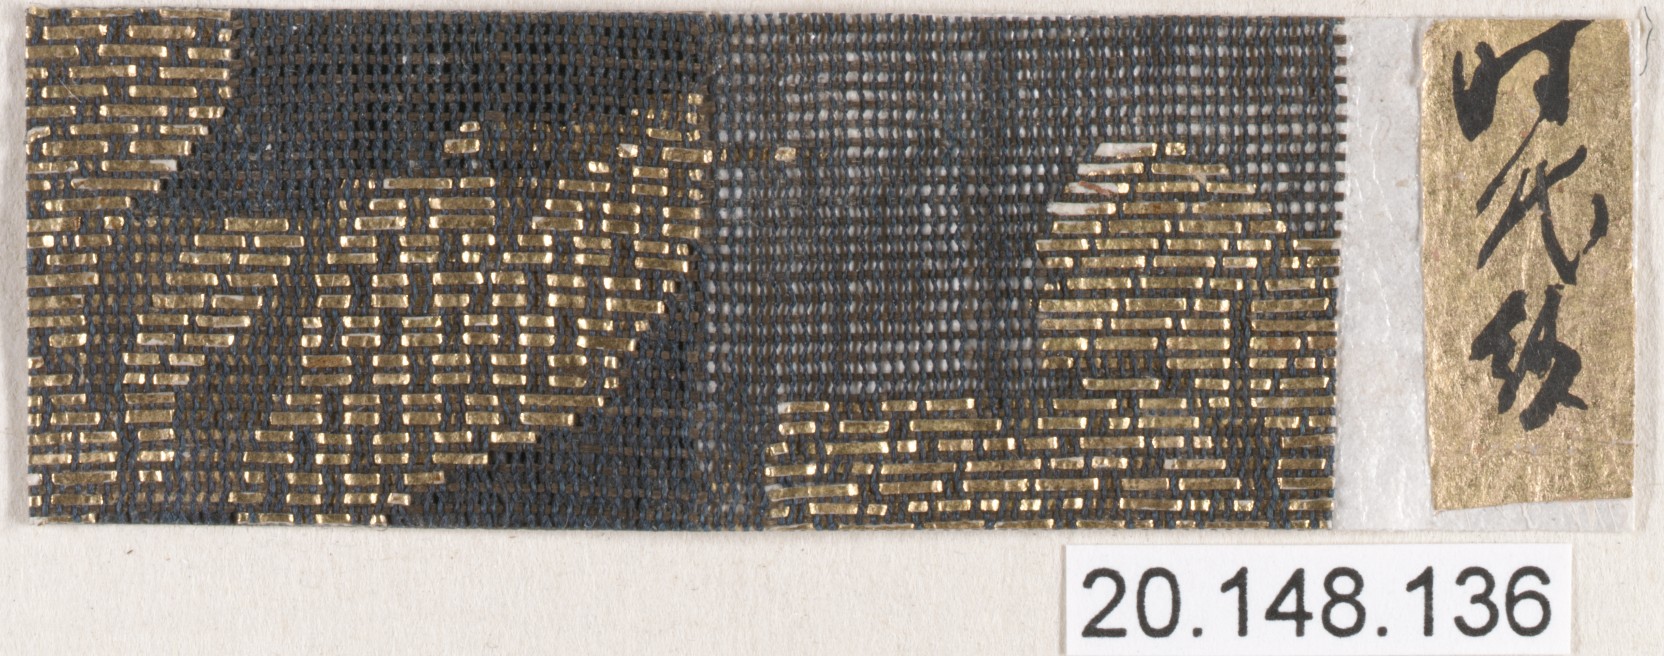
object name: piece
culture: japanese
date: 1601-1700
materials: silk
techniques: compound weave